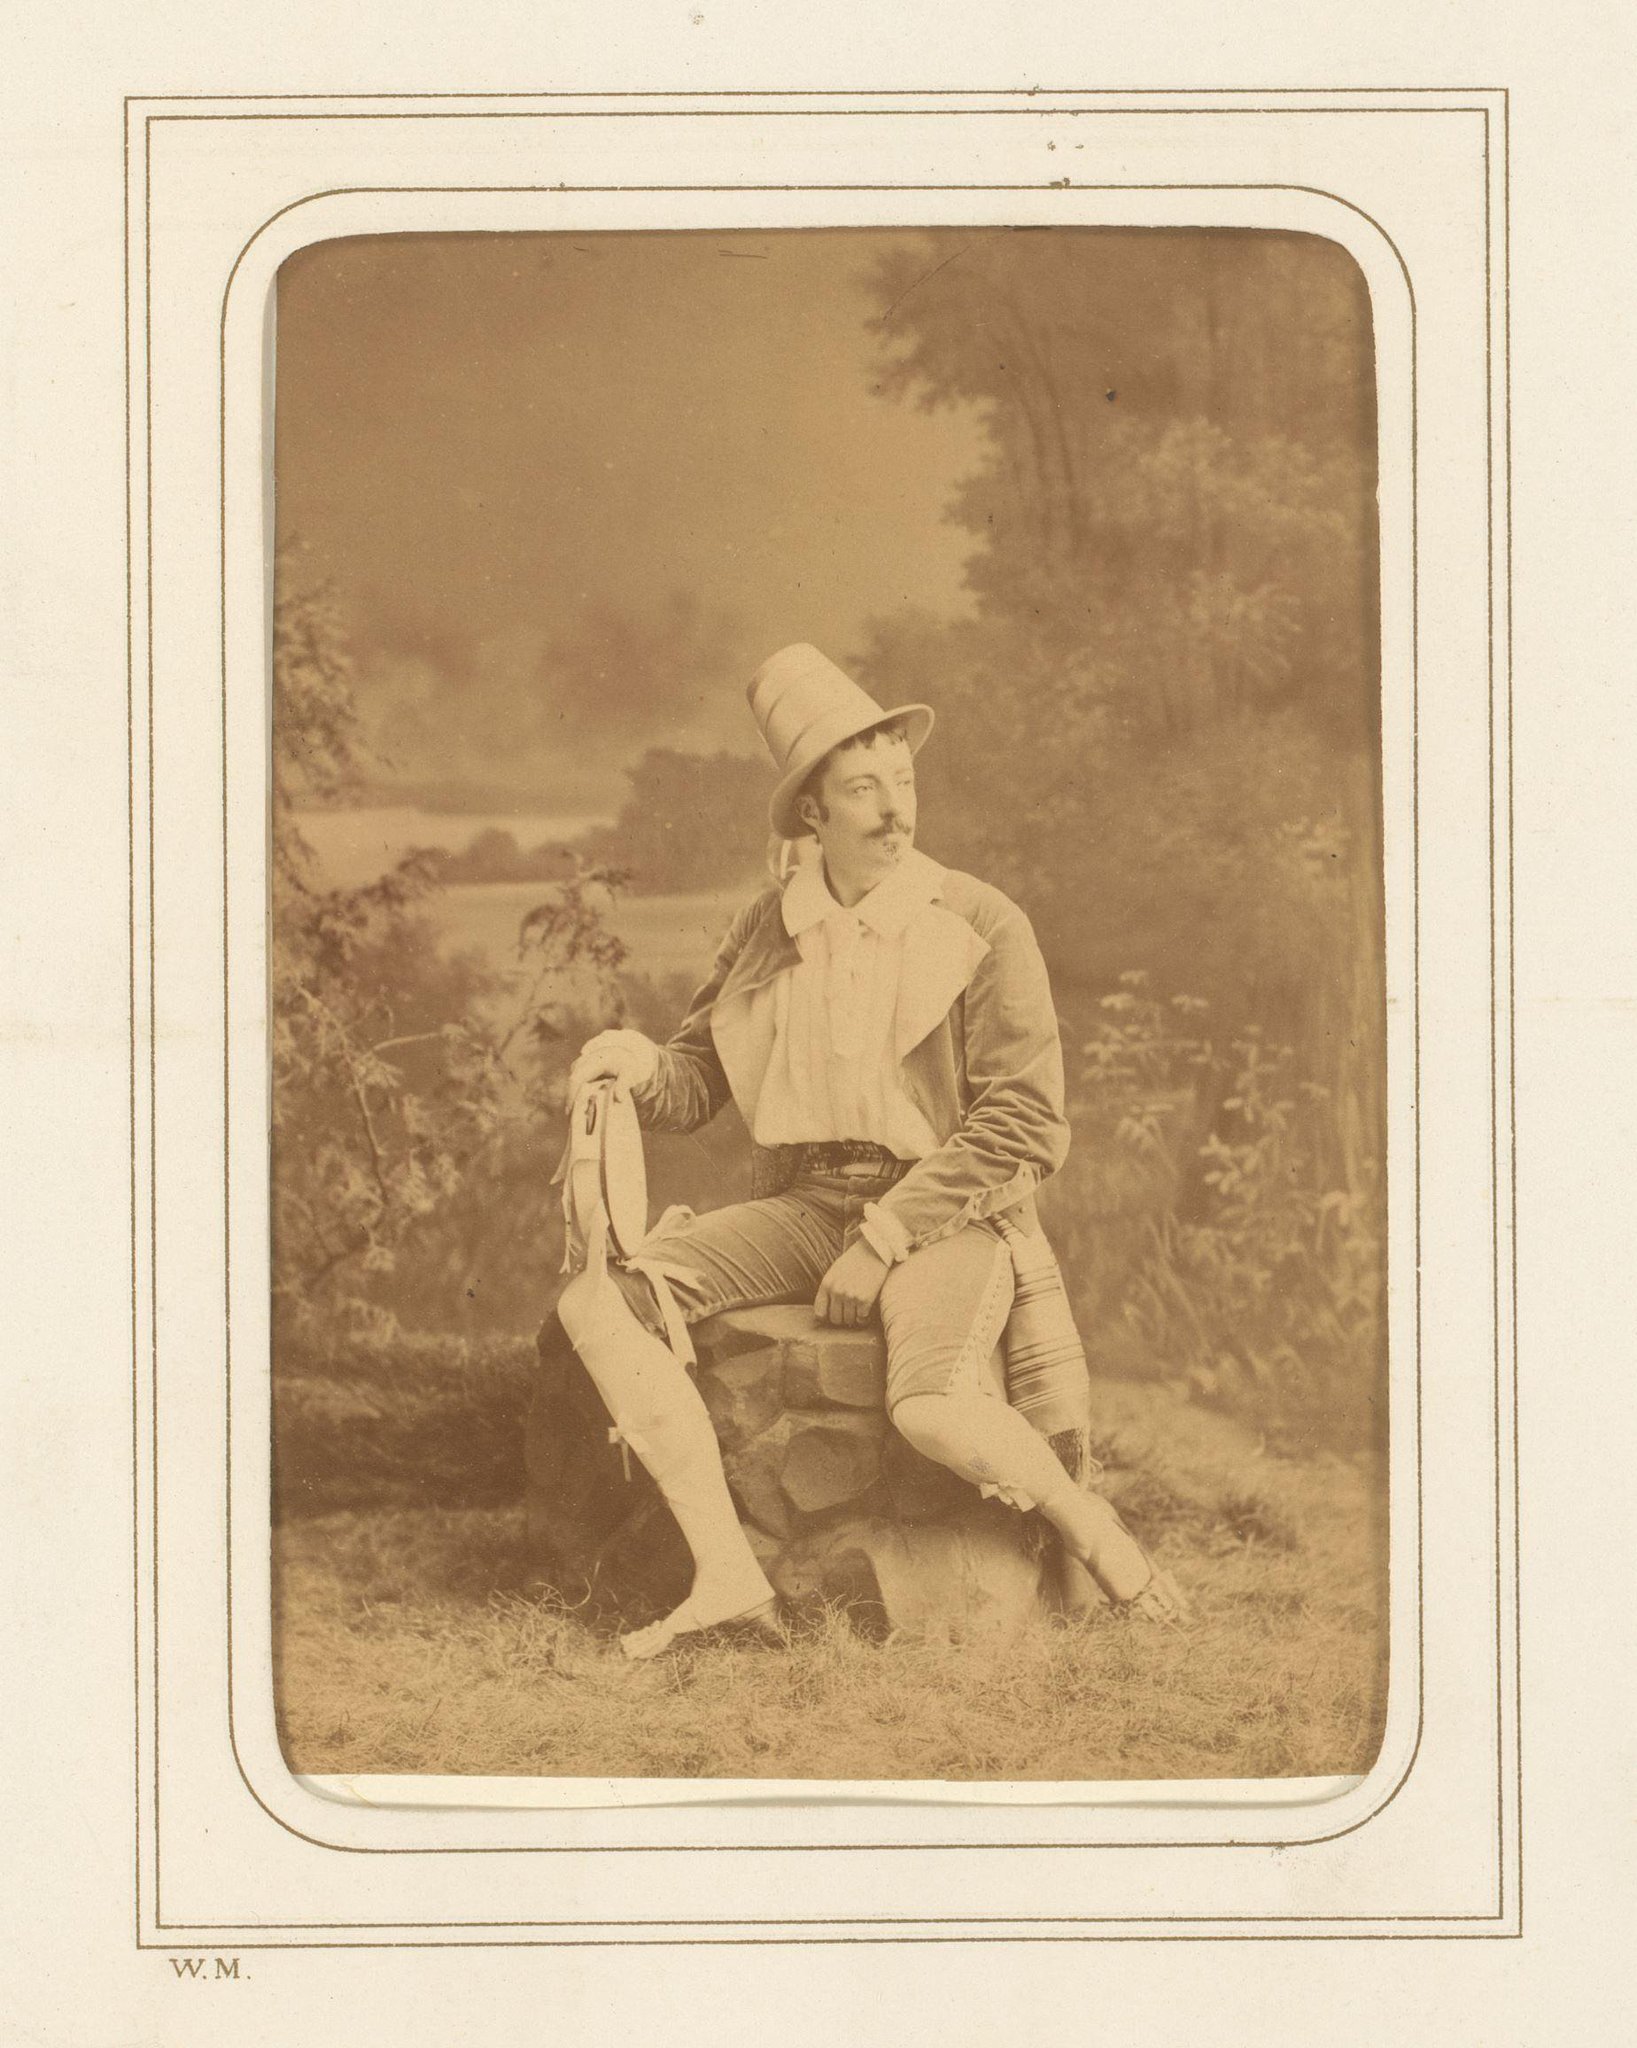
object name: cabinet photograph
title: Portret van een acteur, zittend in een decor van een landschap, aangeduid als Michael Aagaard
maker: georg emil hansen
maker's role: fotograaf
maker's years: 1833-1891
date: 1865-1891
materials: cardboard, photographic support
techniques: albumen print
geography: copenhagen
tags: historical persons, portrait of actor, actress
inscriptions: inscription: ‘GEORG E. HANSEN/ KONGL-HOF-PHOTOGRAPH/ Noresgade No 61./ KIÖBENHAVN/ PHOT. TO H. R. H. THE PRINCE OF WALES./ PHOTOG. DE LA COUR DE RUSSIE./ PHOT. DE LA COUR DE S.M. LE ROI DES HÉLLÉNES.’, annotation: ‘Michael Aagaard Trescun[.]/ b 17 sept 1845/ [...]’